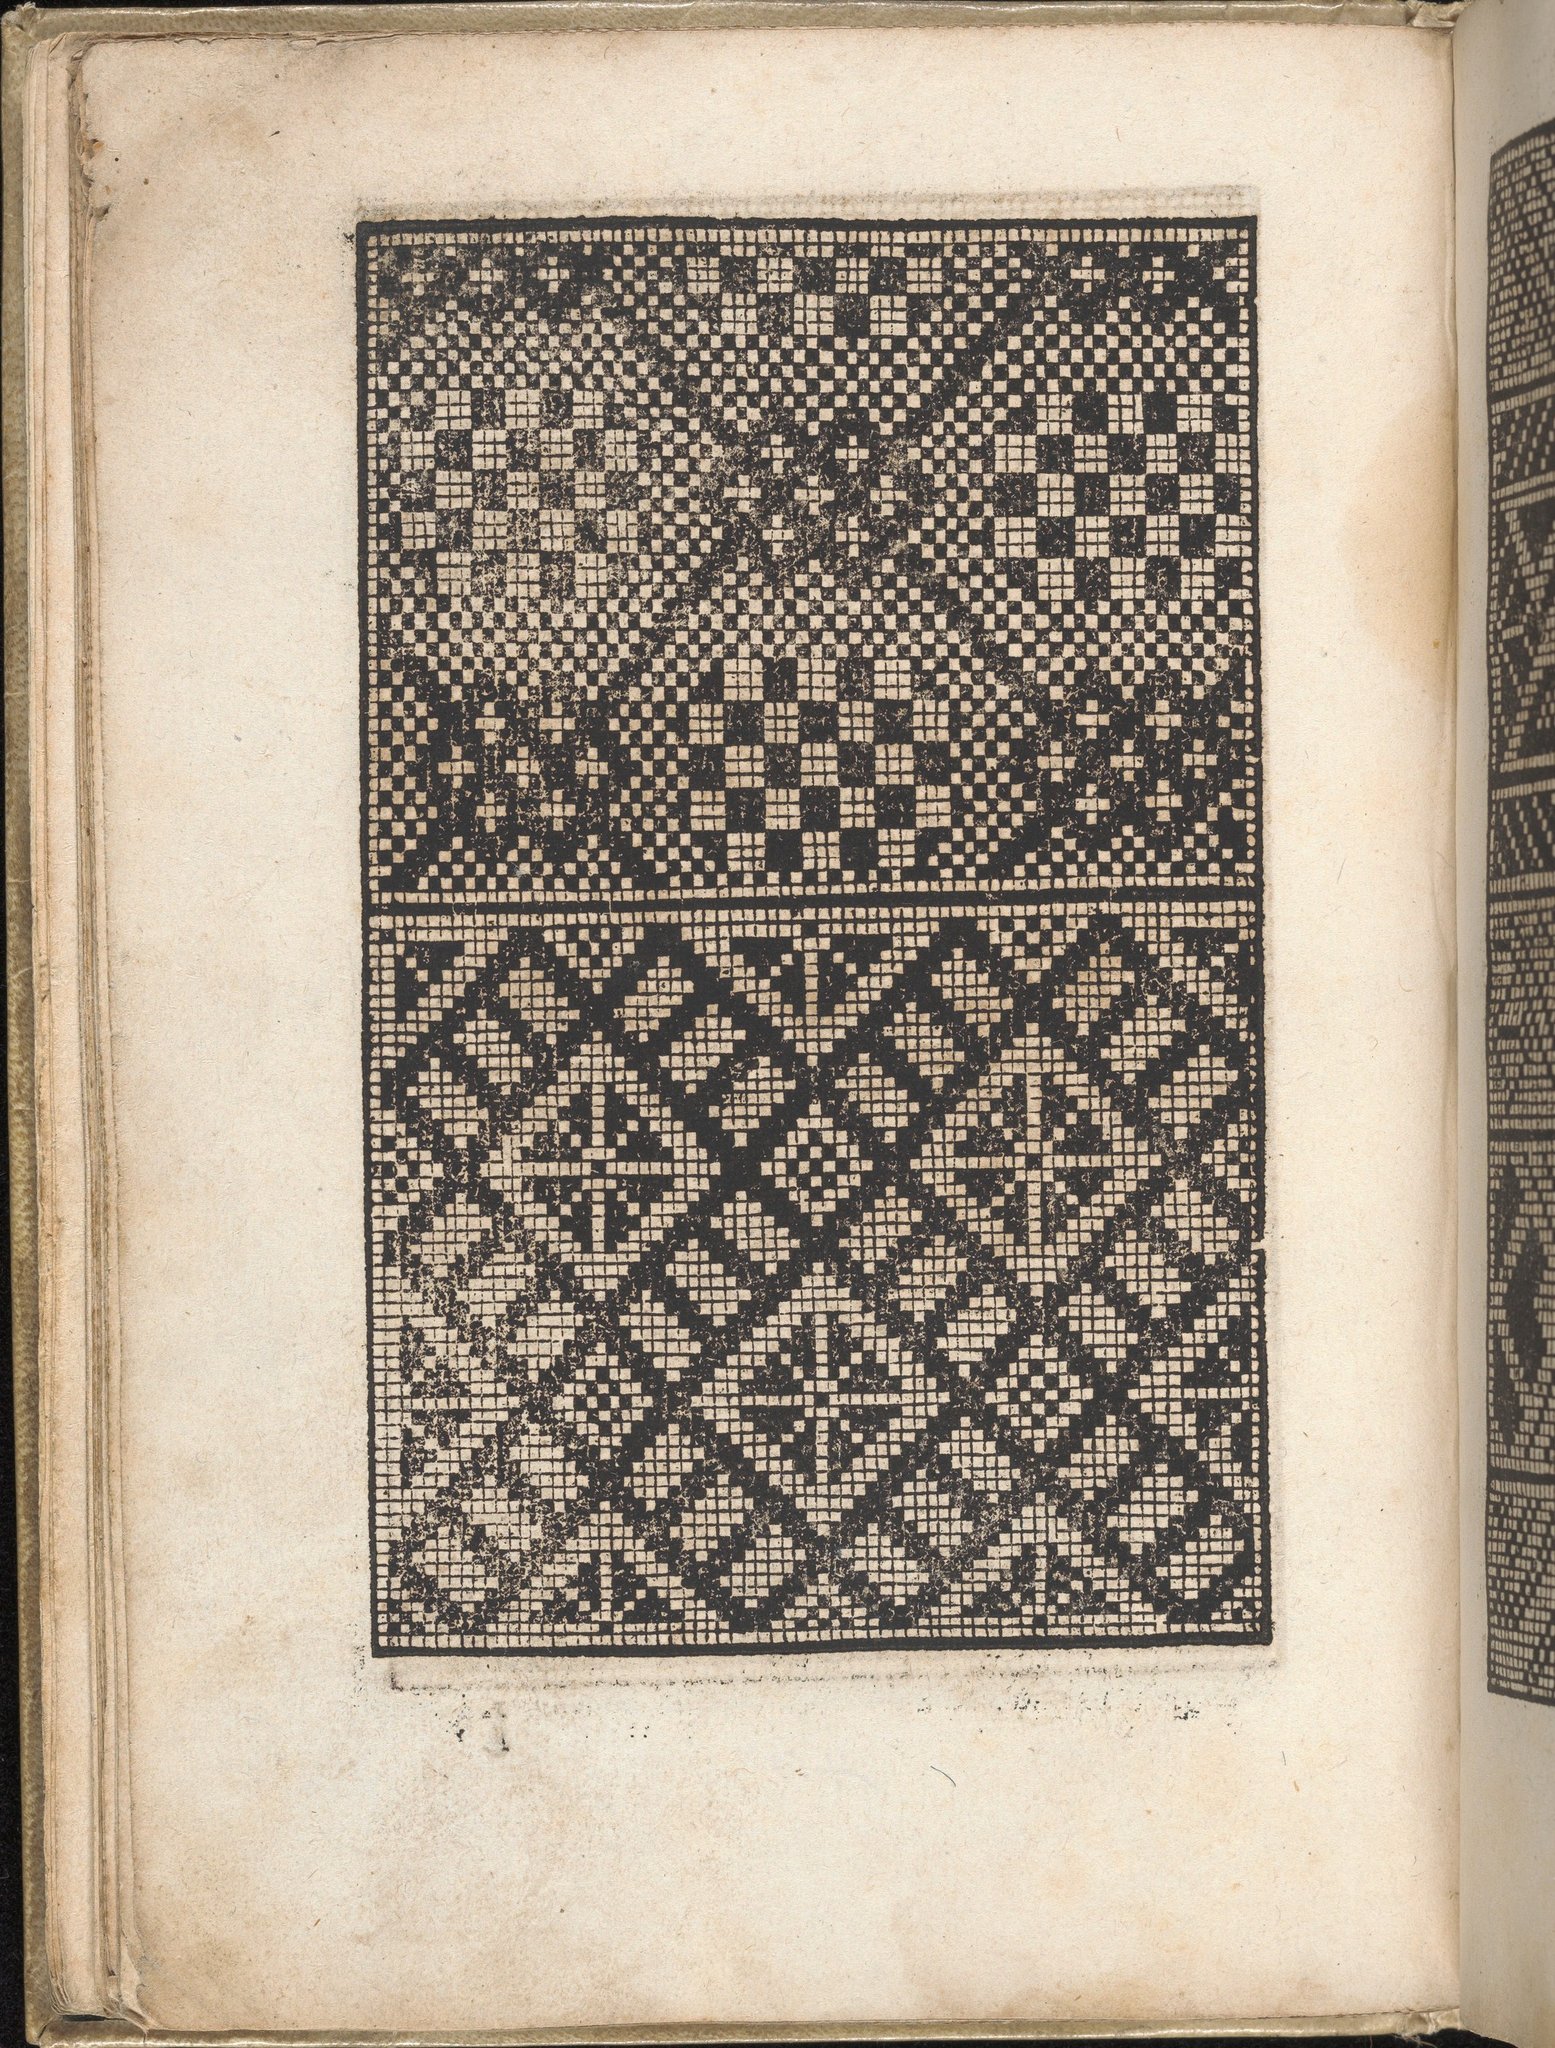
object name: book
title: Page 22v, from "Eyn New Kunstlichboich"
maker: peter quentel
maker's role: publisher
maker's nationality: german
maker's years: 1500-1550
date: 1529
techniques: woodcut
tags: ornament